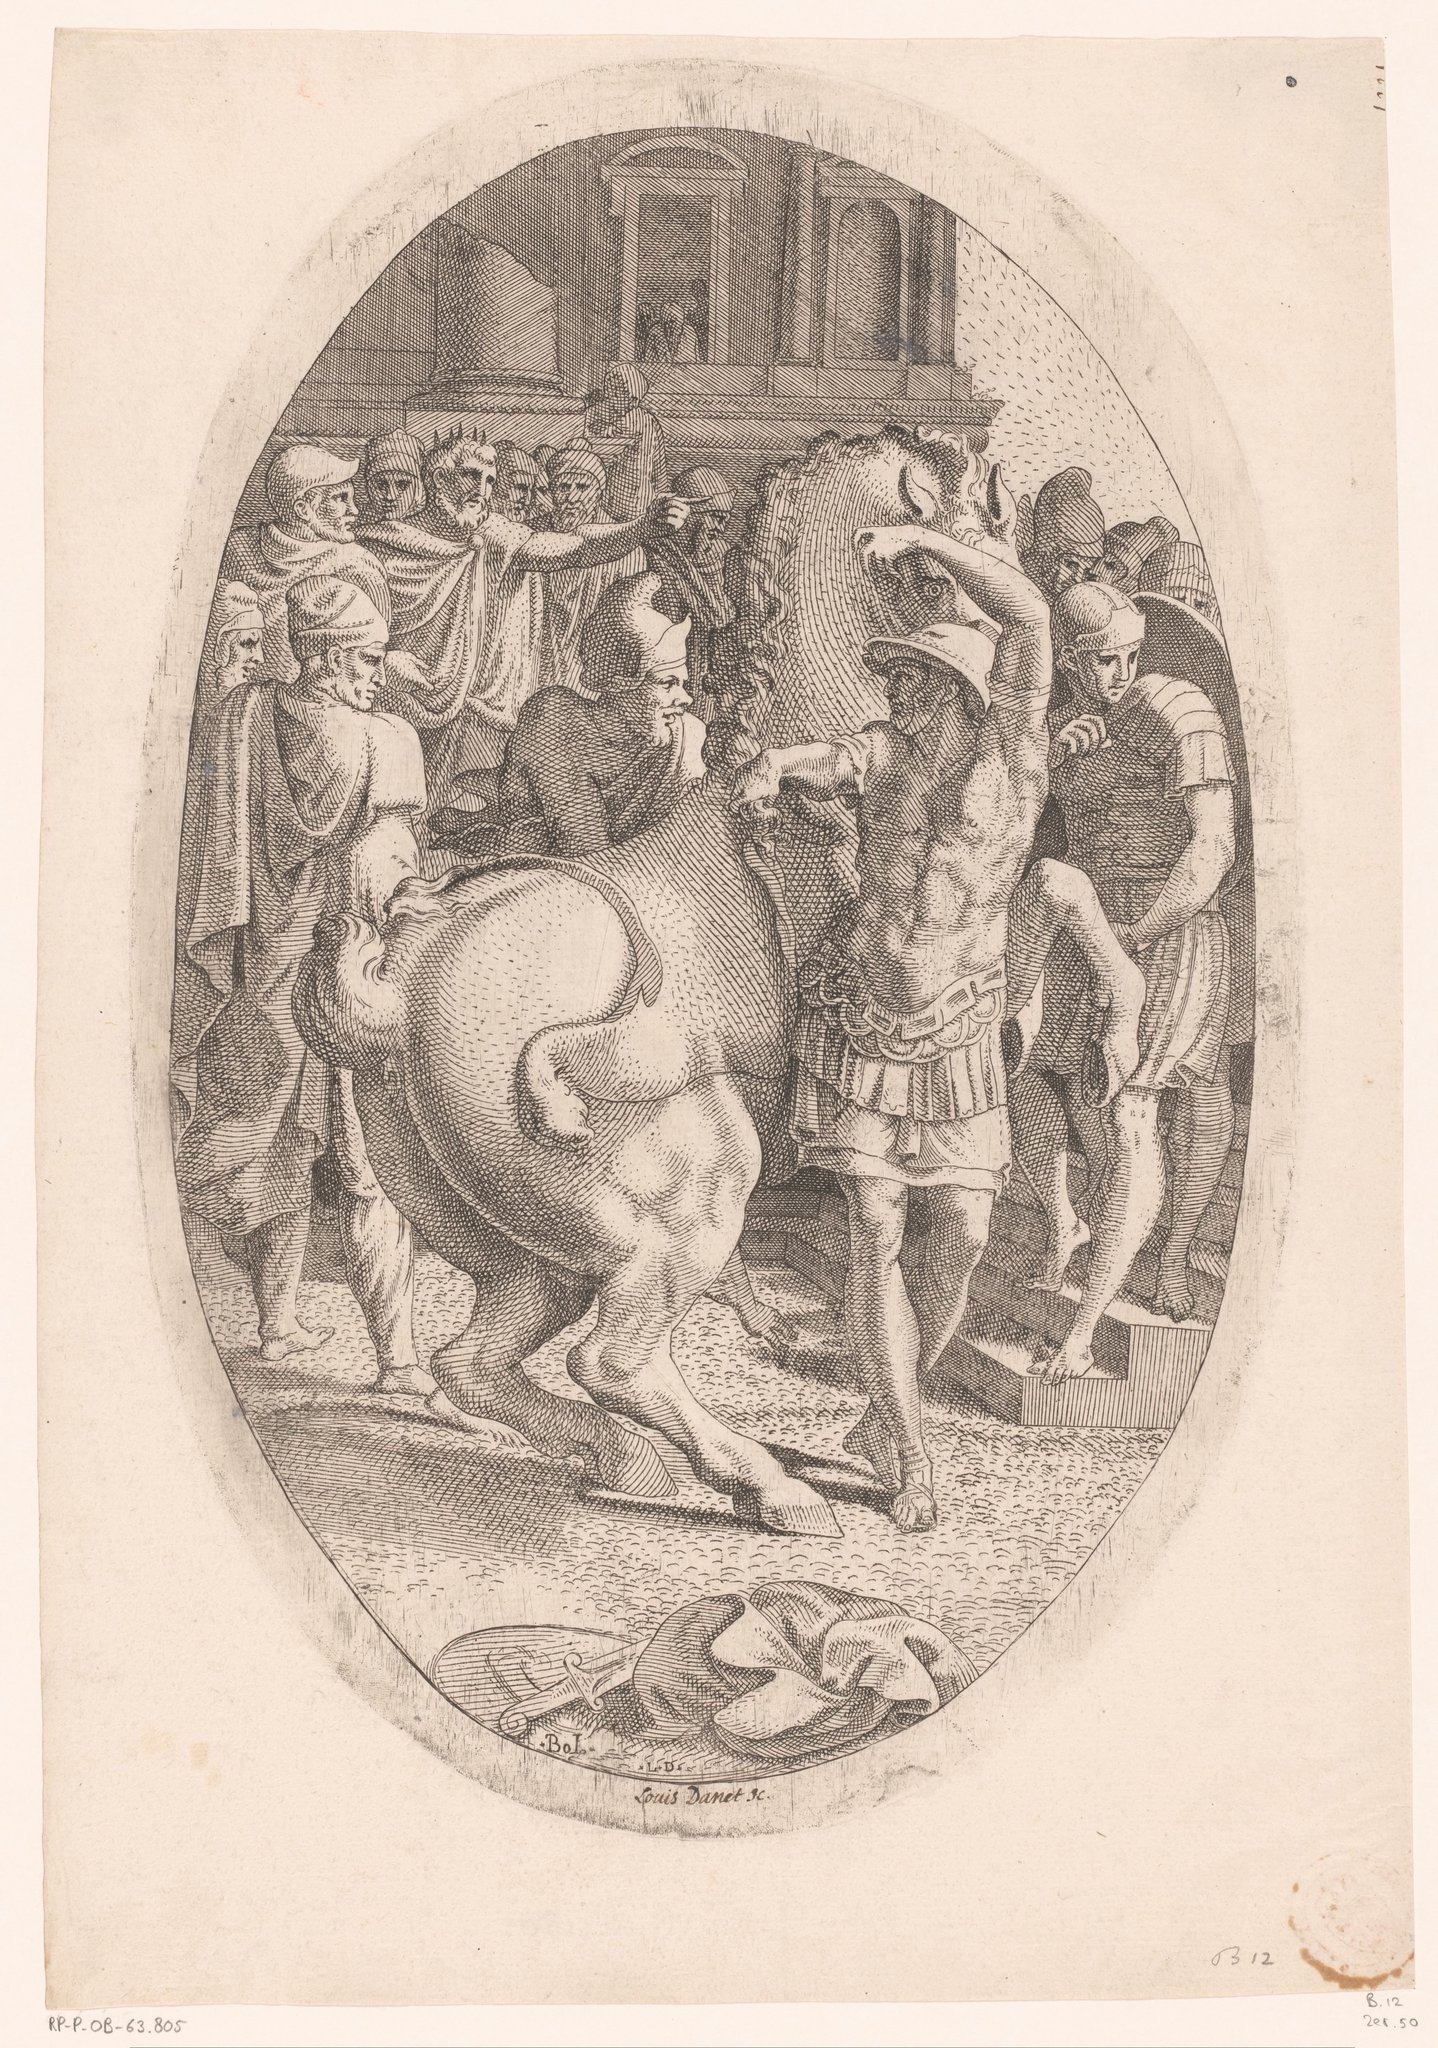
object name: print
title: Alexander temt Bucephalus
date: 1540-1556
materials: paper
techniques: etching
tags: alexander tames bucephalus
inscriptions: collector's mark: Lugt 240